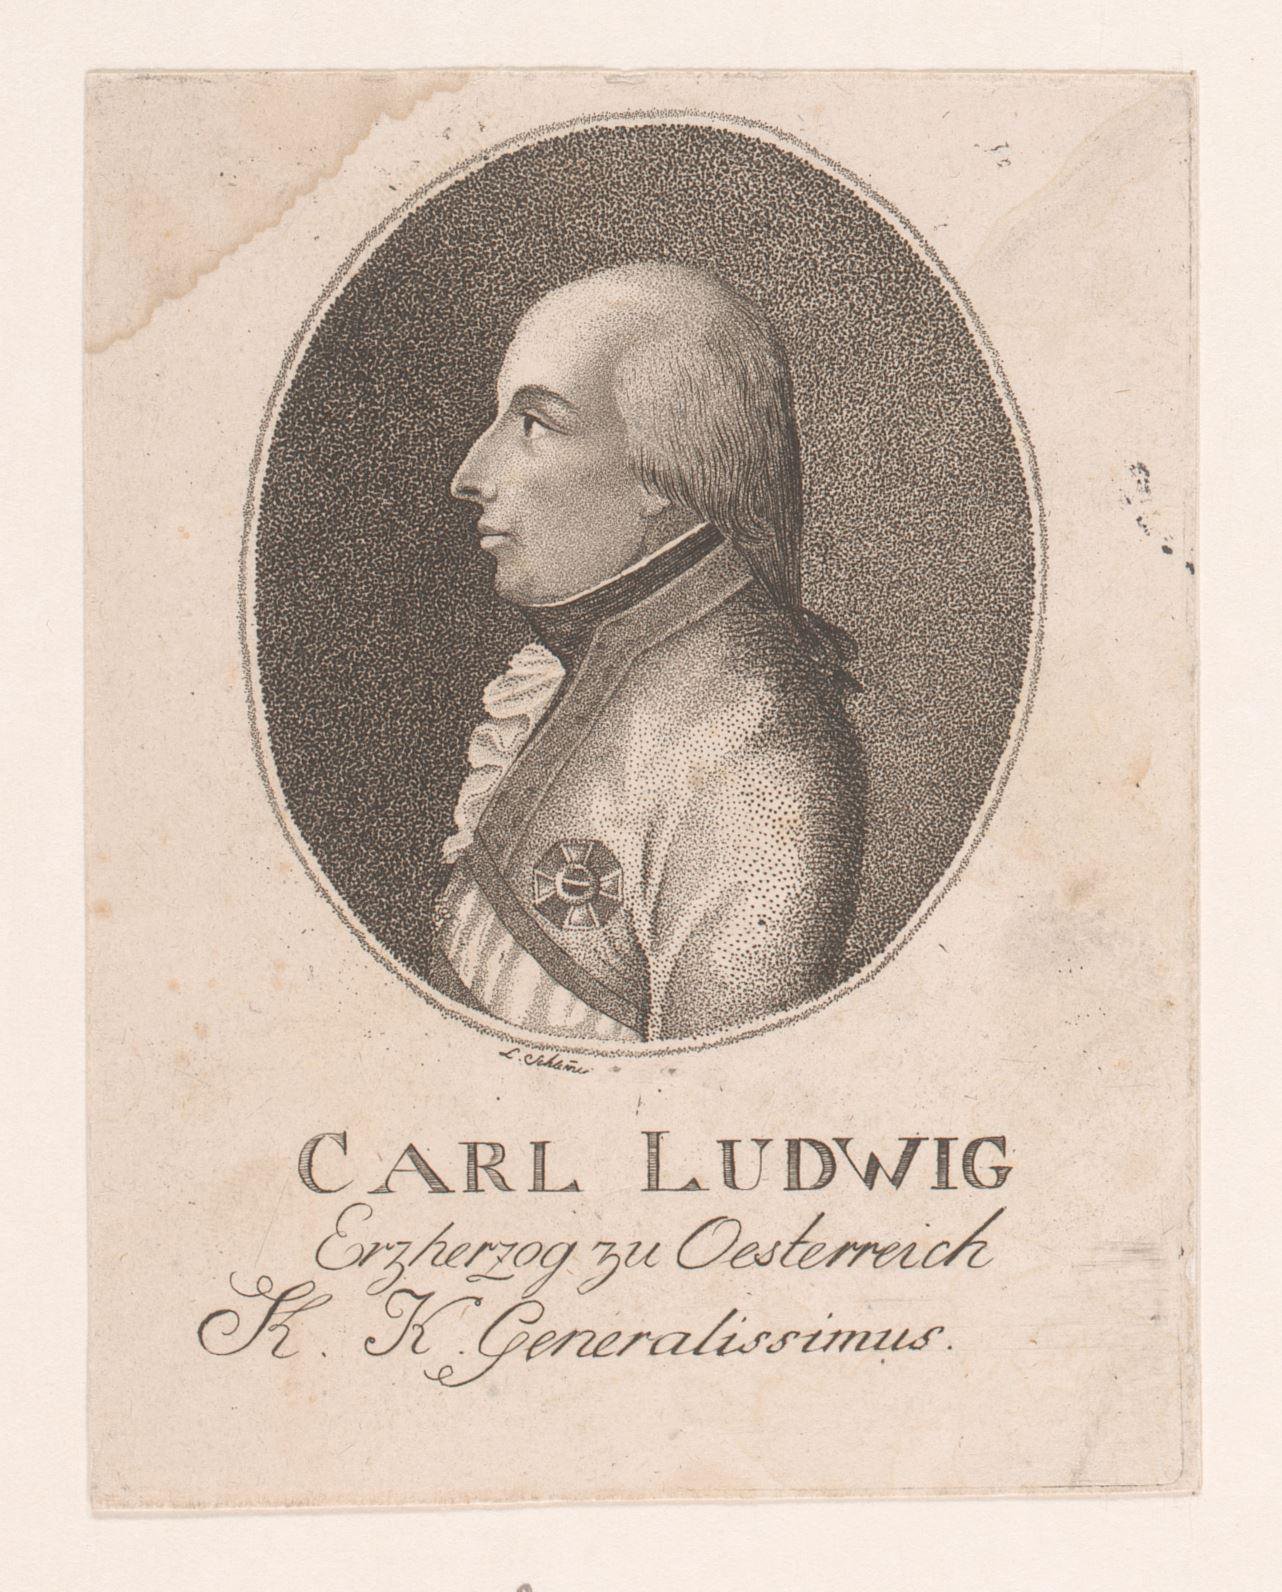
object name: print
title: Portret van Karel Lodewijk Johan, landvoogd der zuidelijke Nederlanden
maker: leonhard schlemmer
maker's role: print maker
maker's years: 1772-1848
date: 1782-1818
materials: paper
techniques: engraving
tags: vienna, historical persons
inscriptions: collector's mark: Lugt 2228